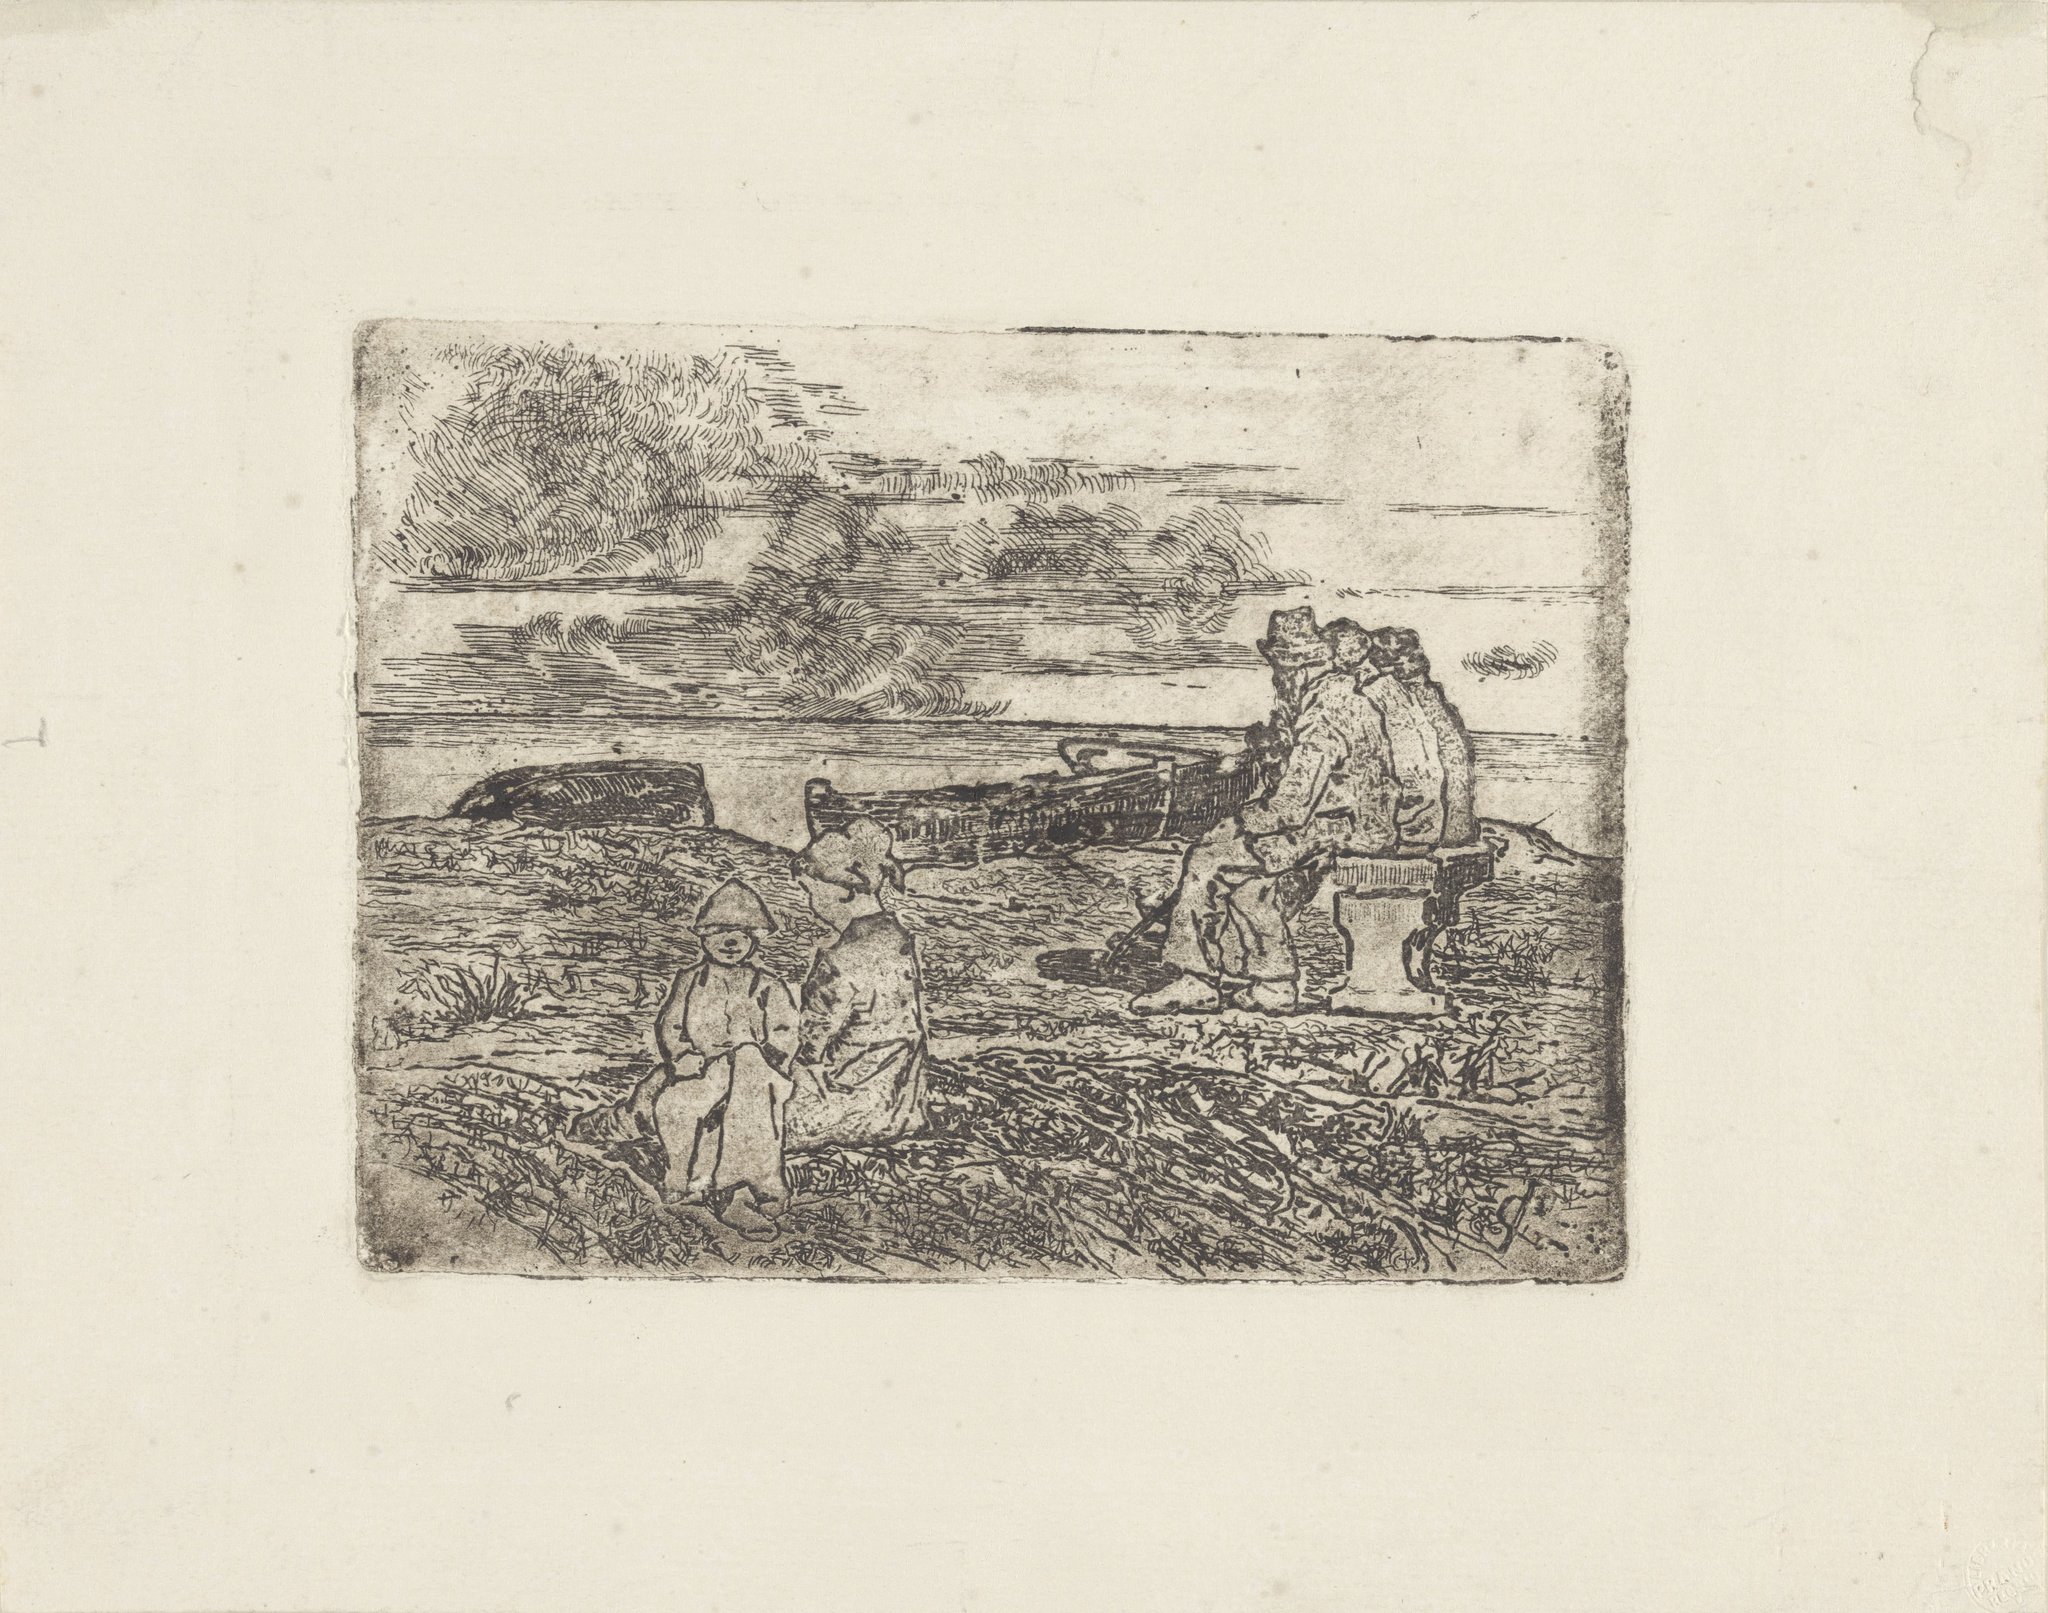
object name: print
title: Rustende figuren aan de kust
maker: giovanni fattori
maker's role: print maker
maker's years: 1825-1908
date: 1835-1908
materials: paper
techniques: etching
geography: italy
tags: resting - bb - out of doors, coastal structures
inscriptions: collector's mark: Lugt 2760, collector's mark: Lugt 2228, collector's mark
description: Kustlandschap met op de voorgrond twee kinderen en rechts drie figuren op een bankje.